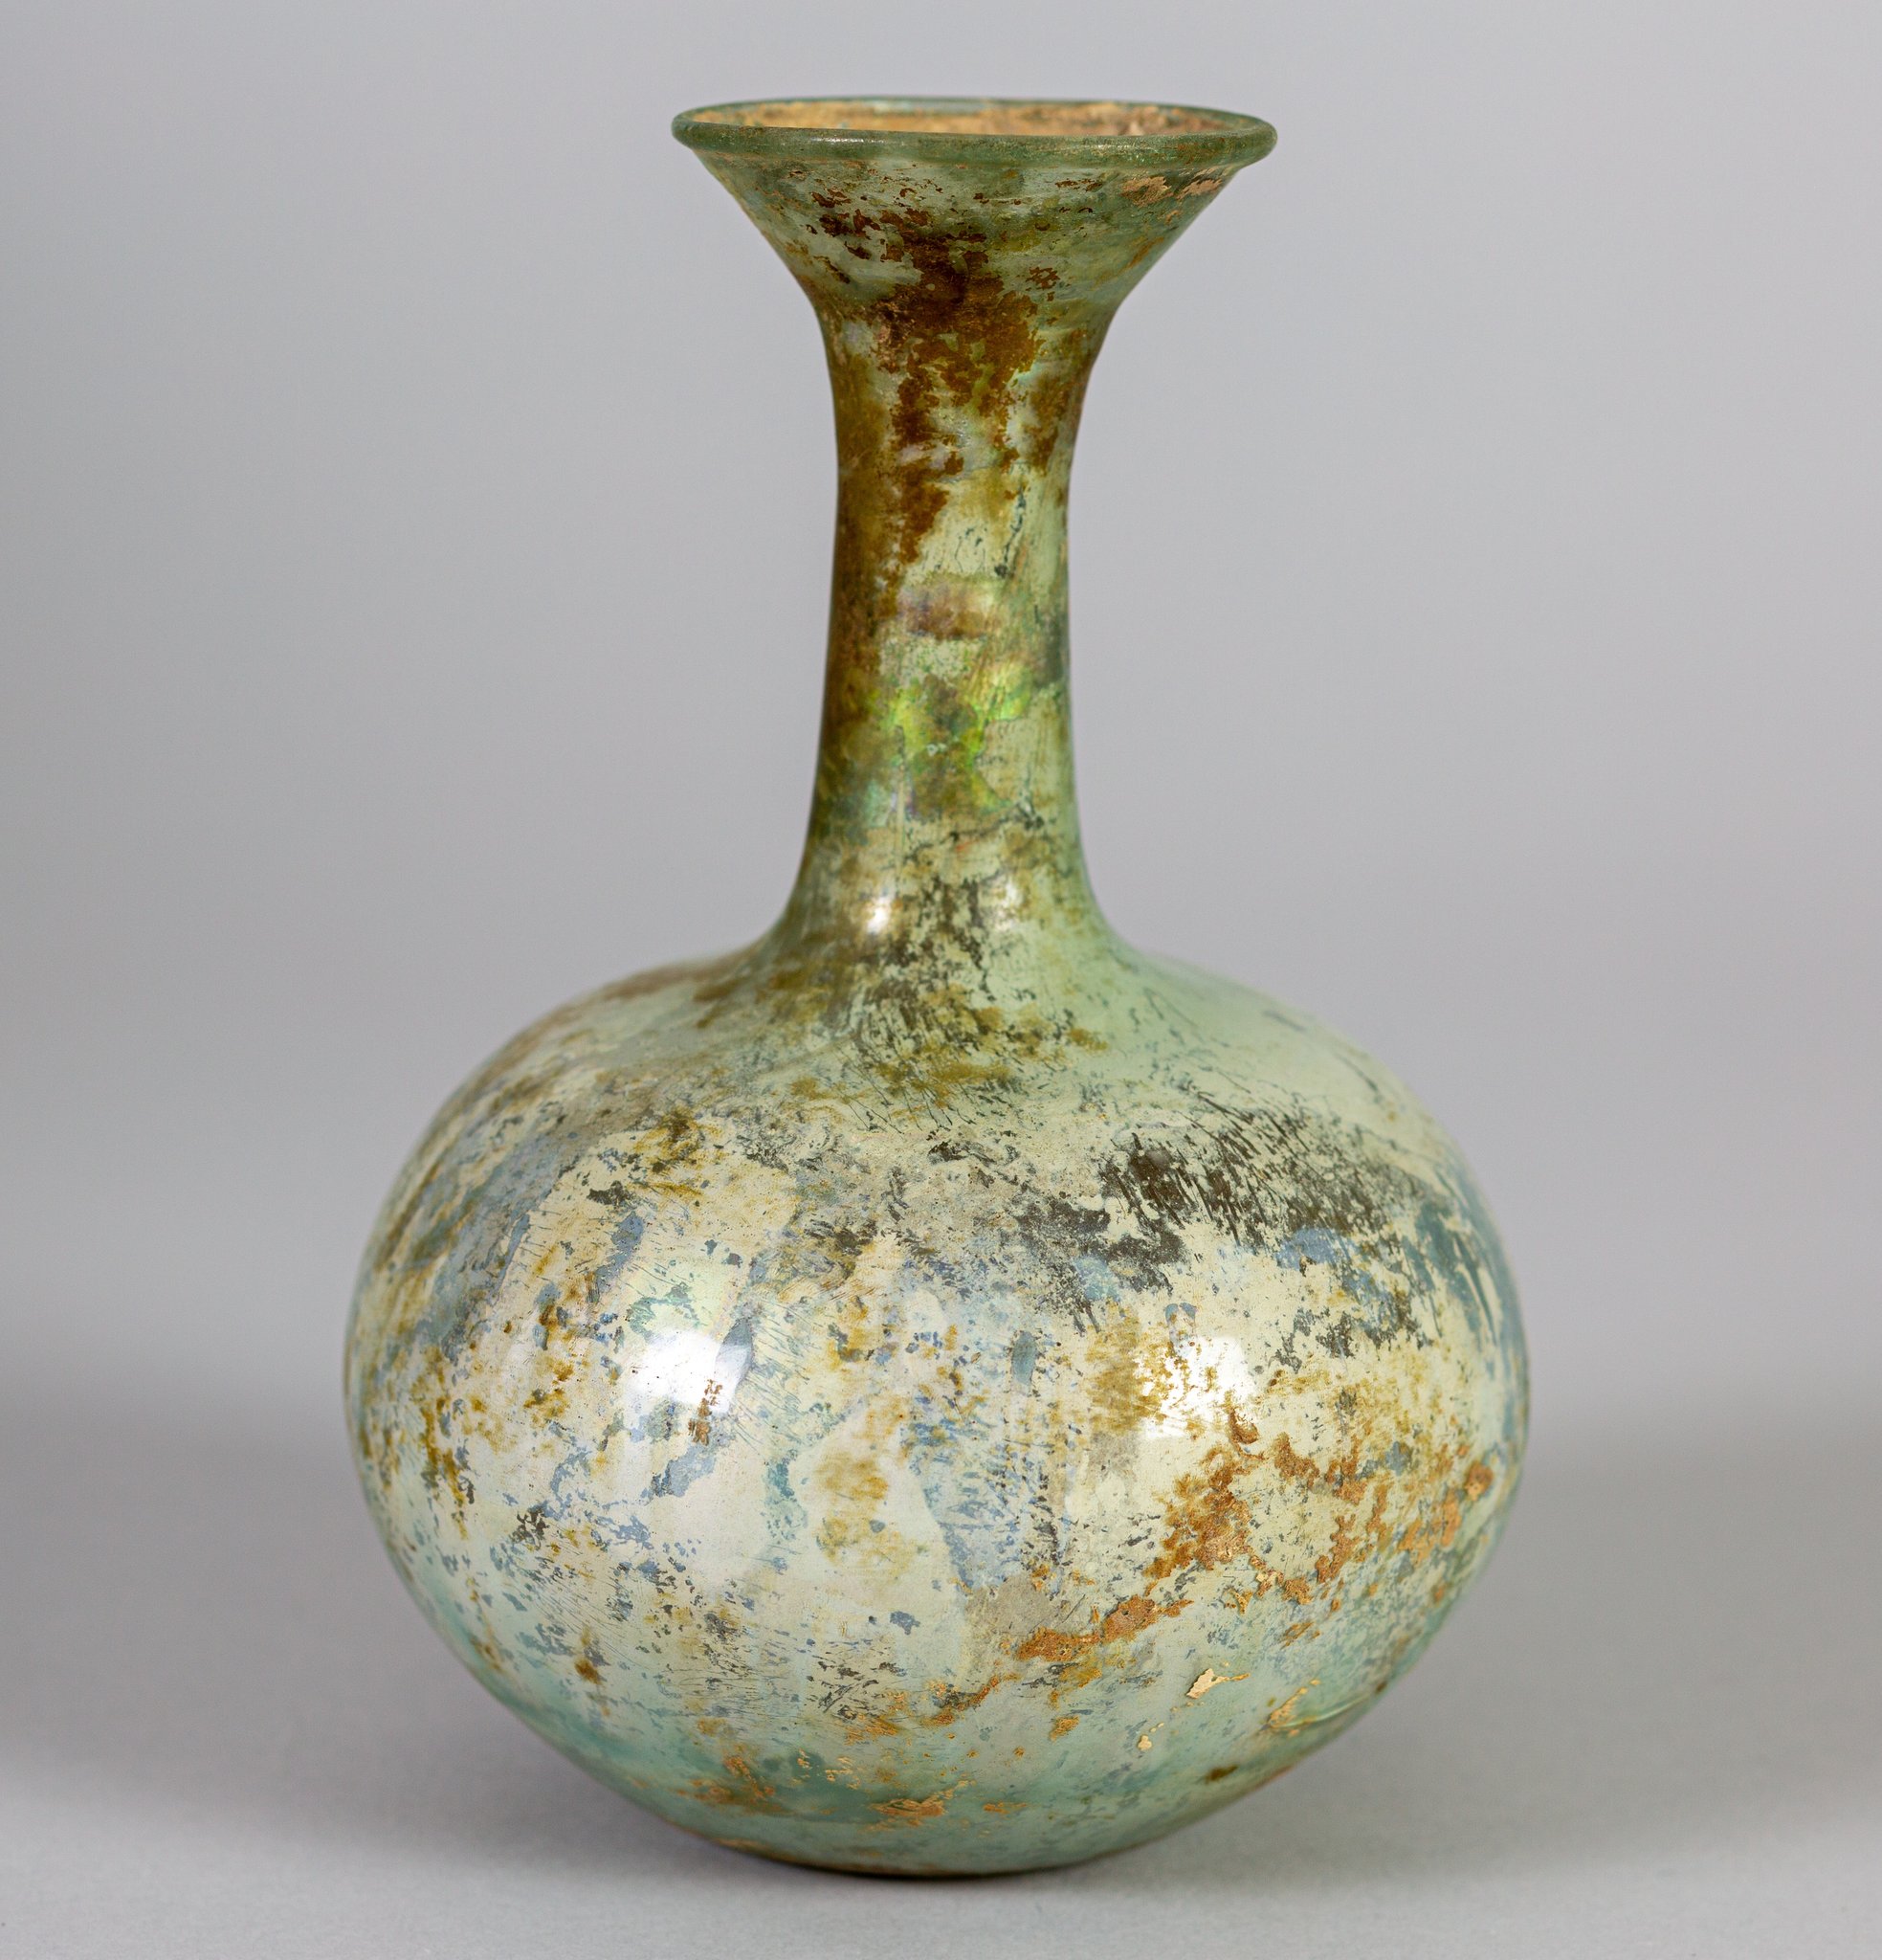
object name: flask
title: Glass flask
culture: roman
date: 301-500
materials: glass